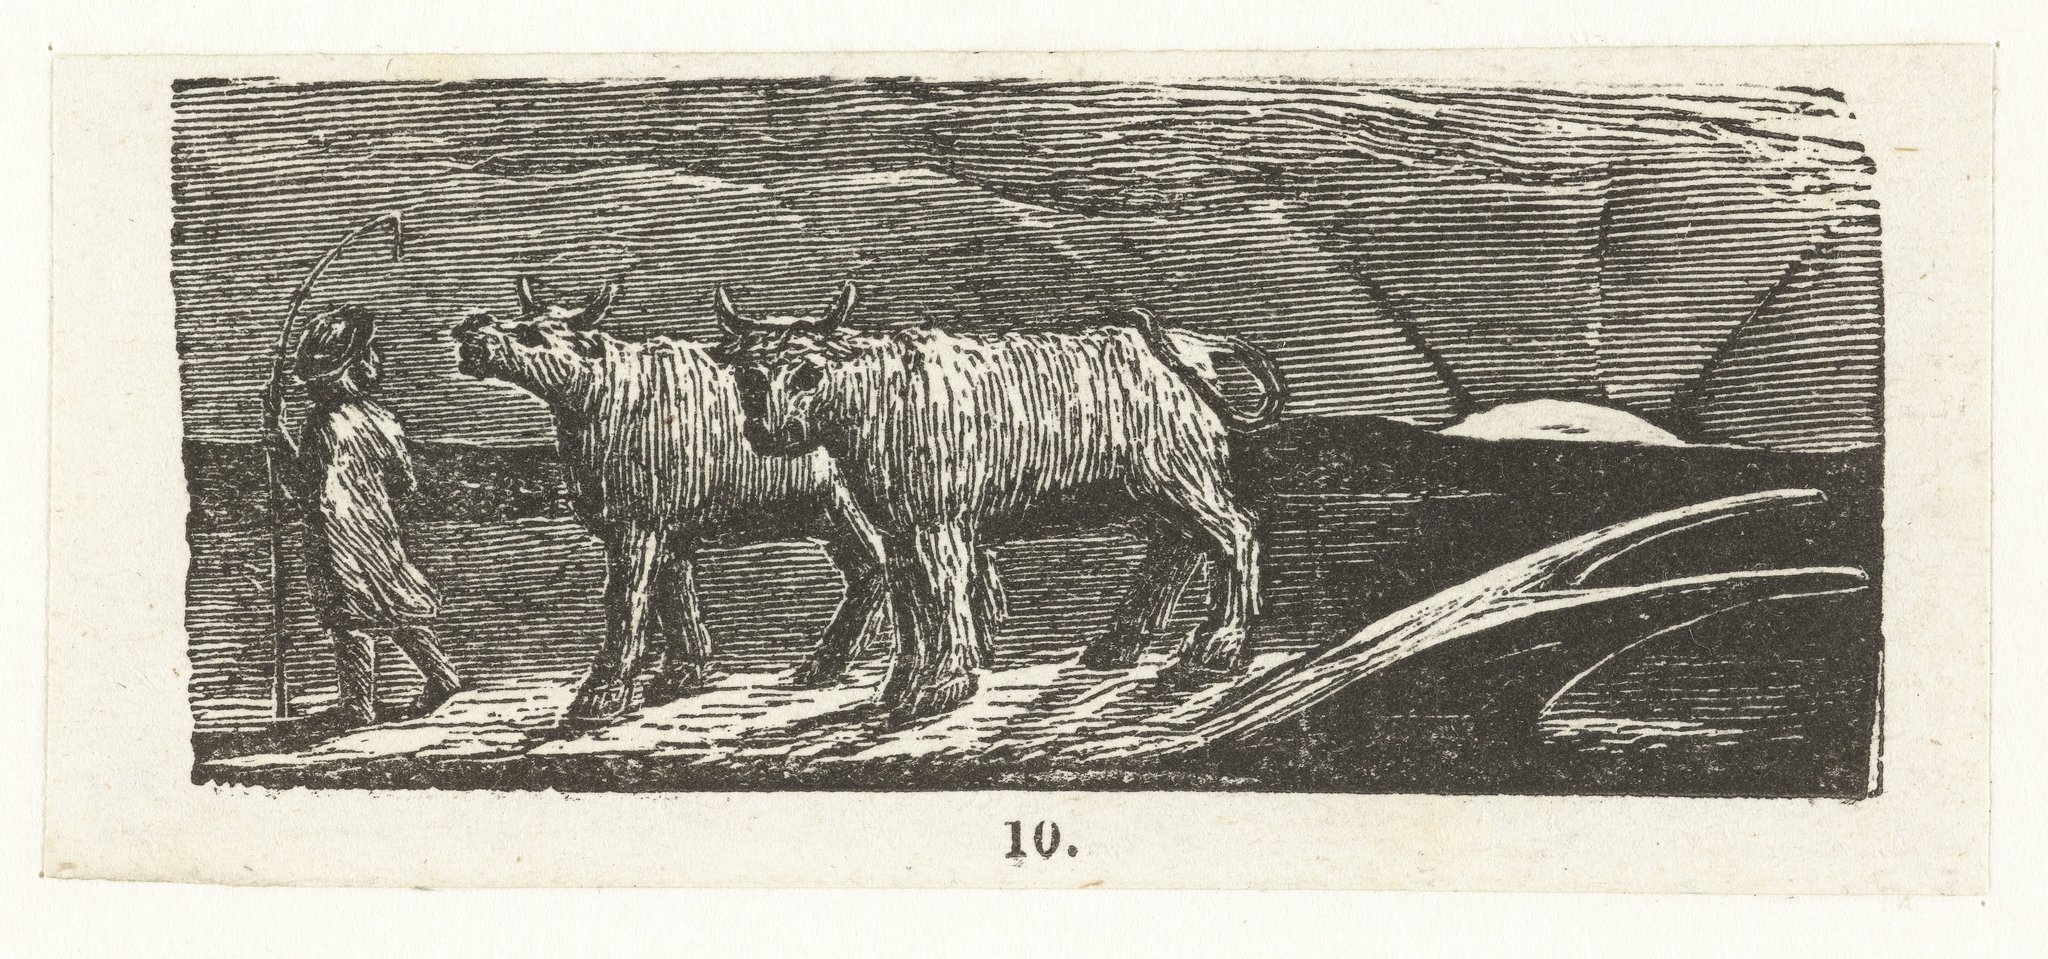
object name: book illustration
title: Terugkeer van de herdersjongen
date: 1820-1821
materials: paper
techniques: engraving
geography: england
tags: herding, herdsman, herdswoman, shepherd, shepherdess, cowherd, etc., illustration ~ printed matter, book, agricultural implements: plough, ox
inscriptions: inscription: ‘10.’, collector's mark: Lugt 2228, collector's mark: Lugt 2760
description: Illustratie uit "Imitations of Ecologue I", de achttiende-eeuwse imitatie van de eerste Ecloge van Vergilius, geschreven door Ambrose Philips, waarin twee herders Thenot and Colinet met elkaar converseren. De prent maakt deel uit van een serie houtgravures die als illustratie was bedoeld voor het schoolboek "The Pastorals of Virgil", uitgegeven in 1821. De opdracht voor deze prenten is gegeven door Dr R.J. Thornton. Botke, K.